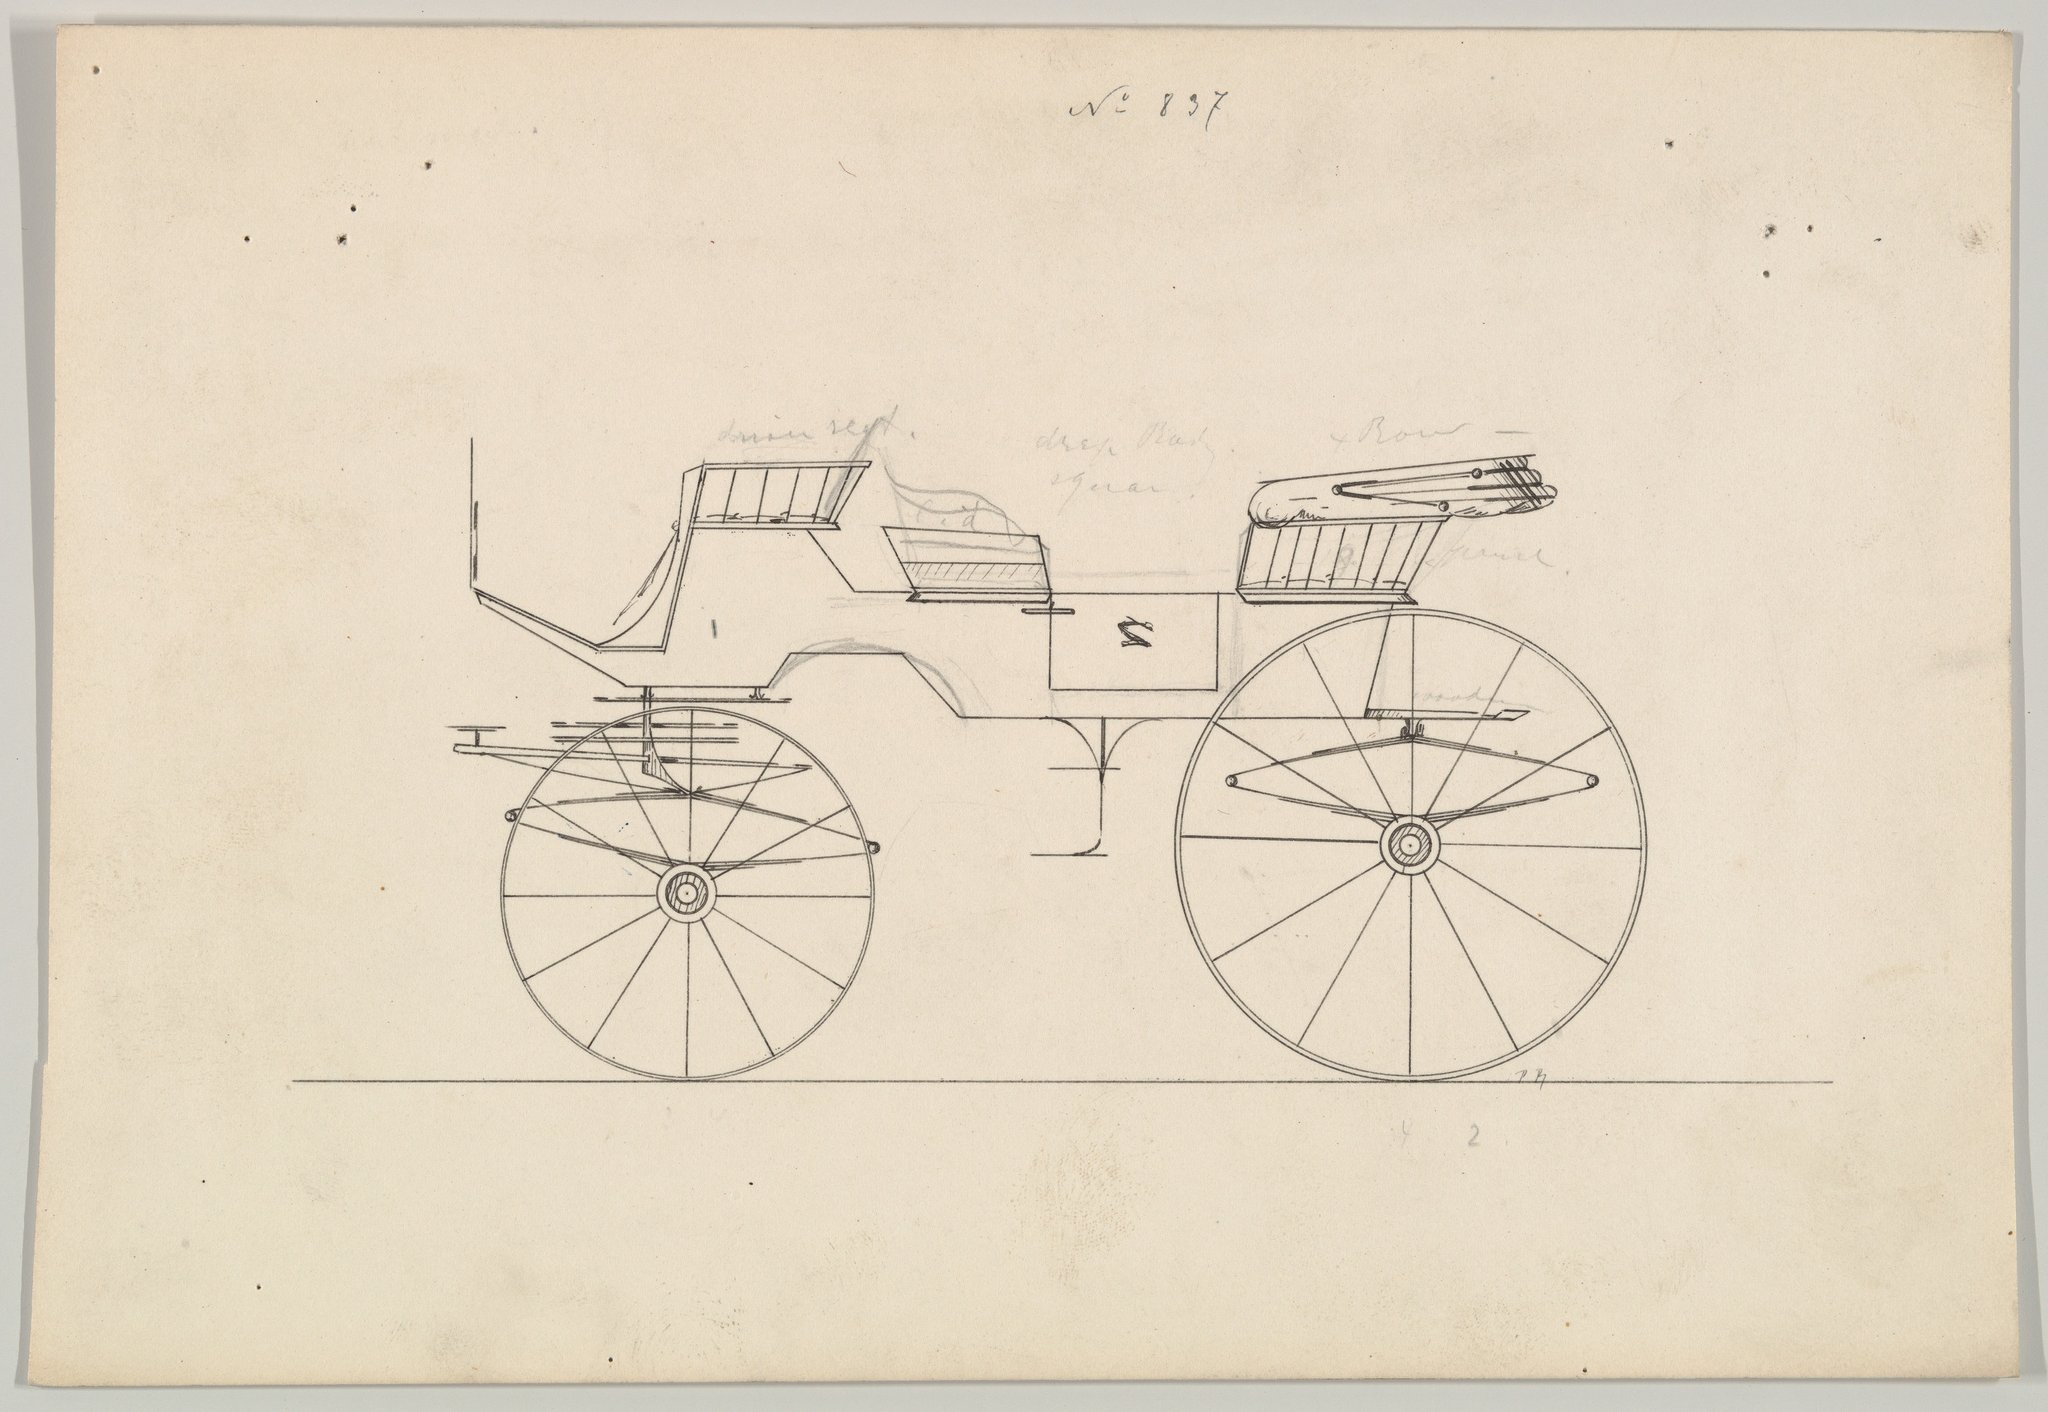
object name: drawing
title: Design for Vis-à-vis/ Charabanc, no. 837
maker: brewster & co.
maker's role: manufacturer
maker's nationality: american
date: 1850-1870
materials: graphite, ink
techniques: pen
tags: carriages